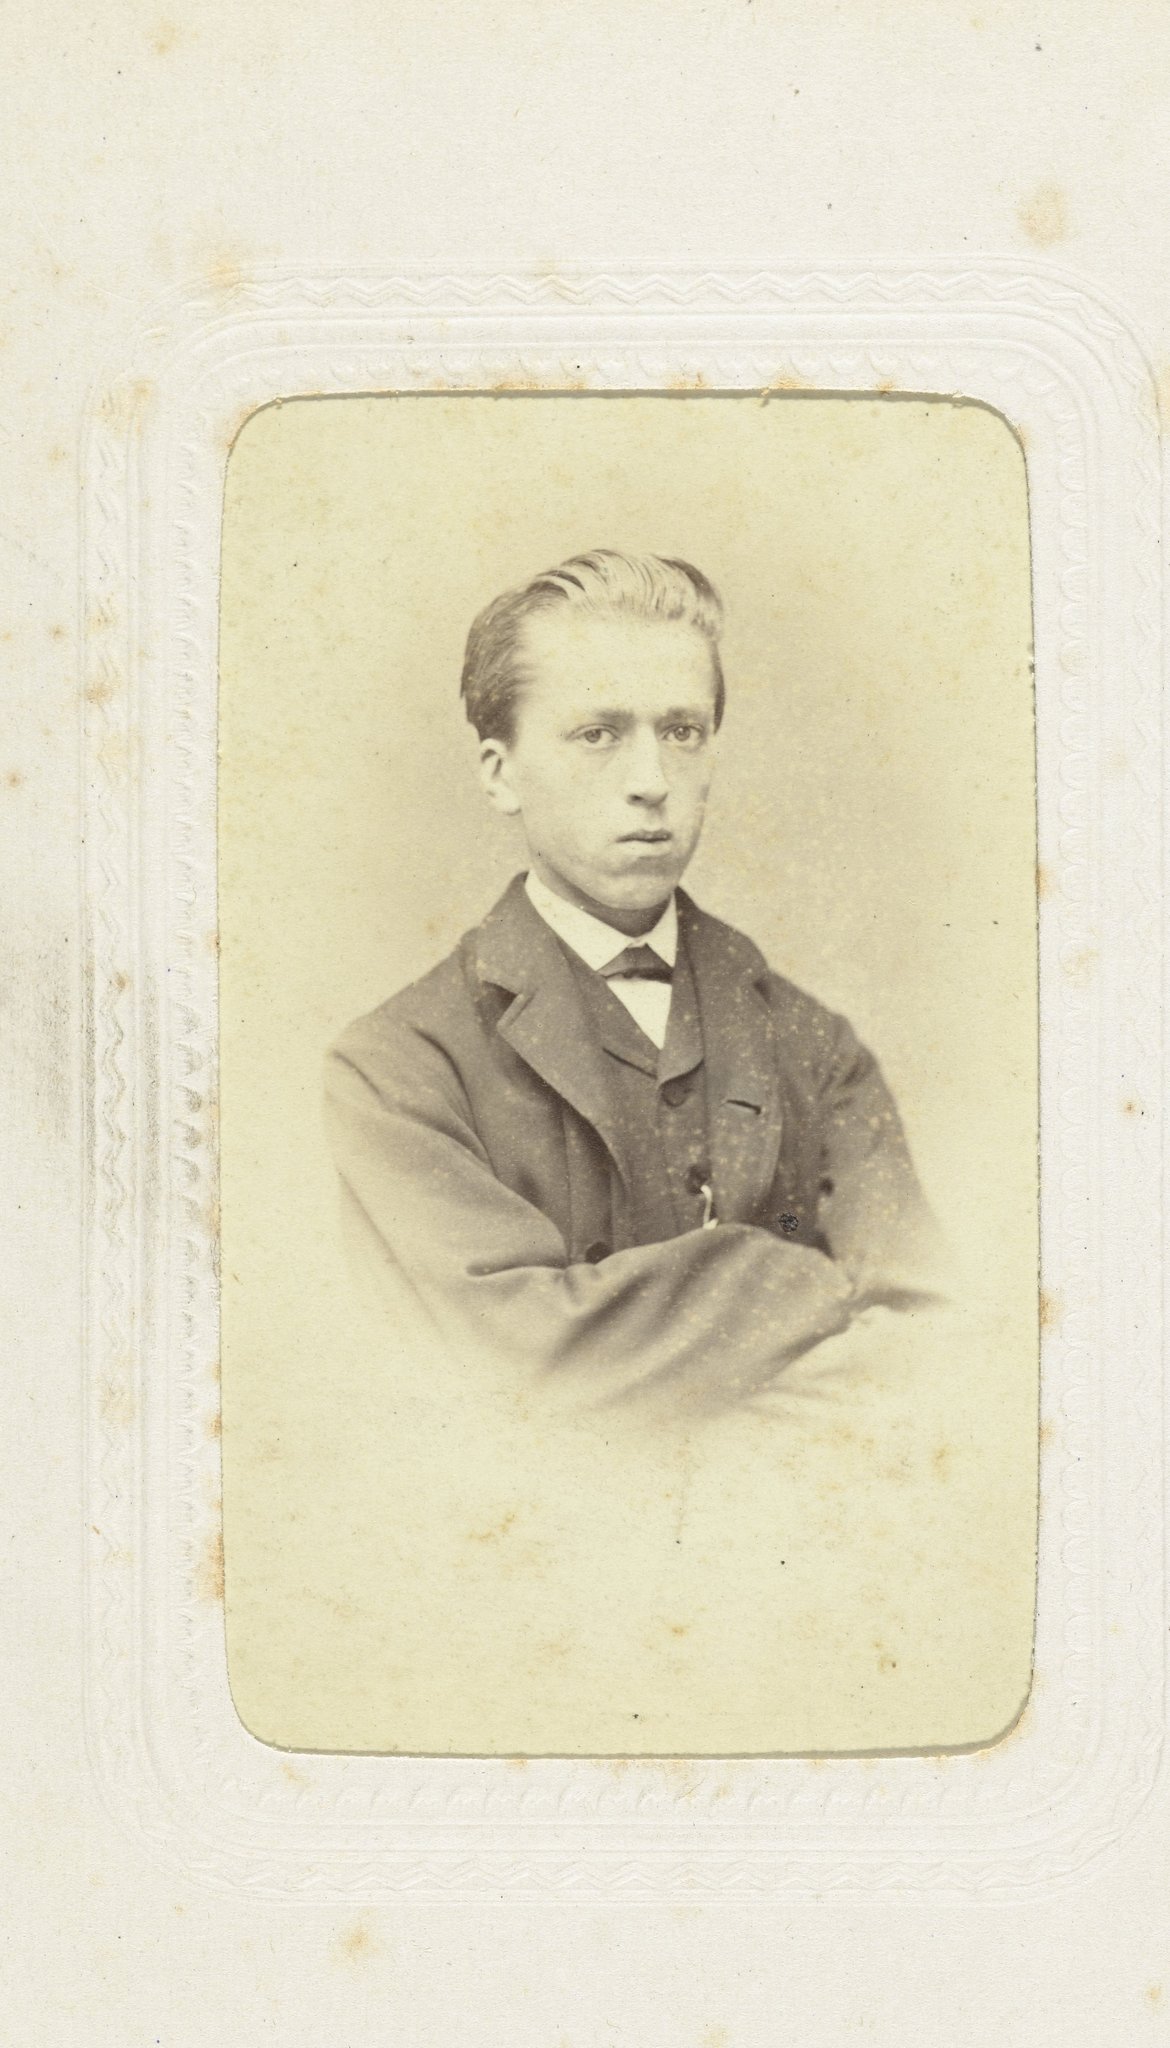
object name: carte de visite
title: Studioportret van een jongen in een te groot pak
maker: albert greiner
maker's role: fotograaf, fotostudio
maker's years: 1833-1890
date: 1863-1866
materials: cardboard, paper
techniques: albumen print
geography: amsterdam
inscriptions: name: ‘Albert Greiner Amsterdam’